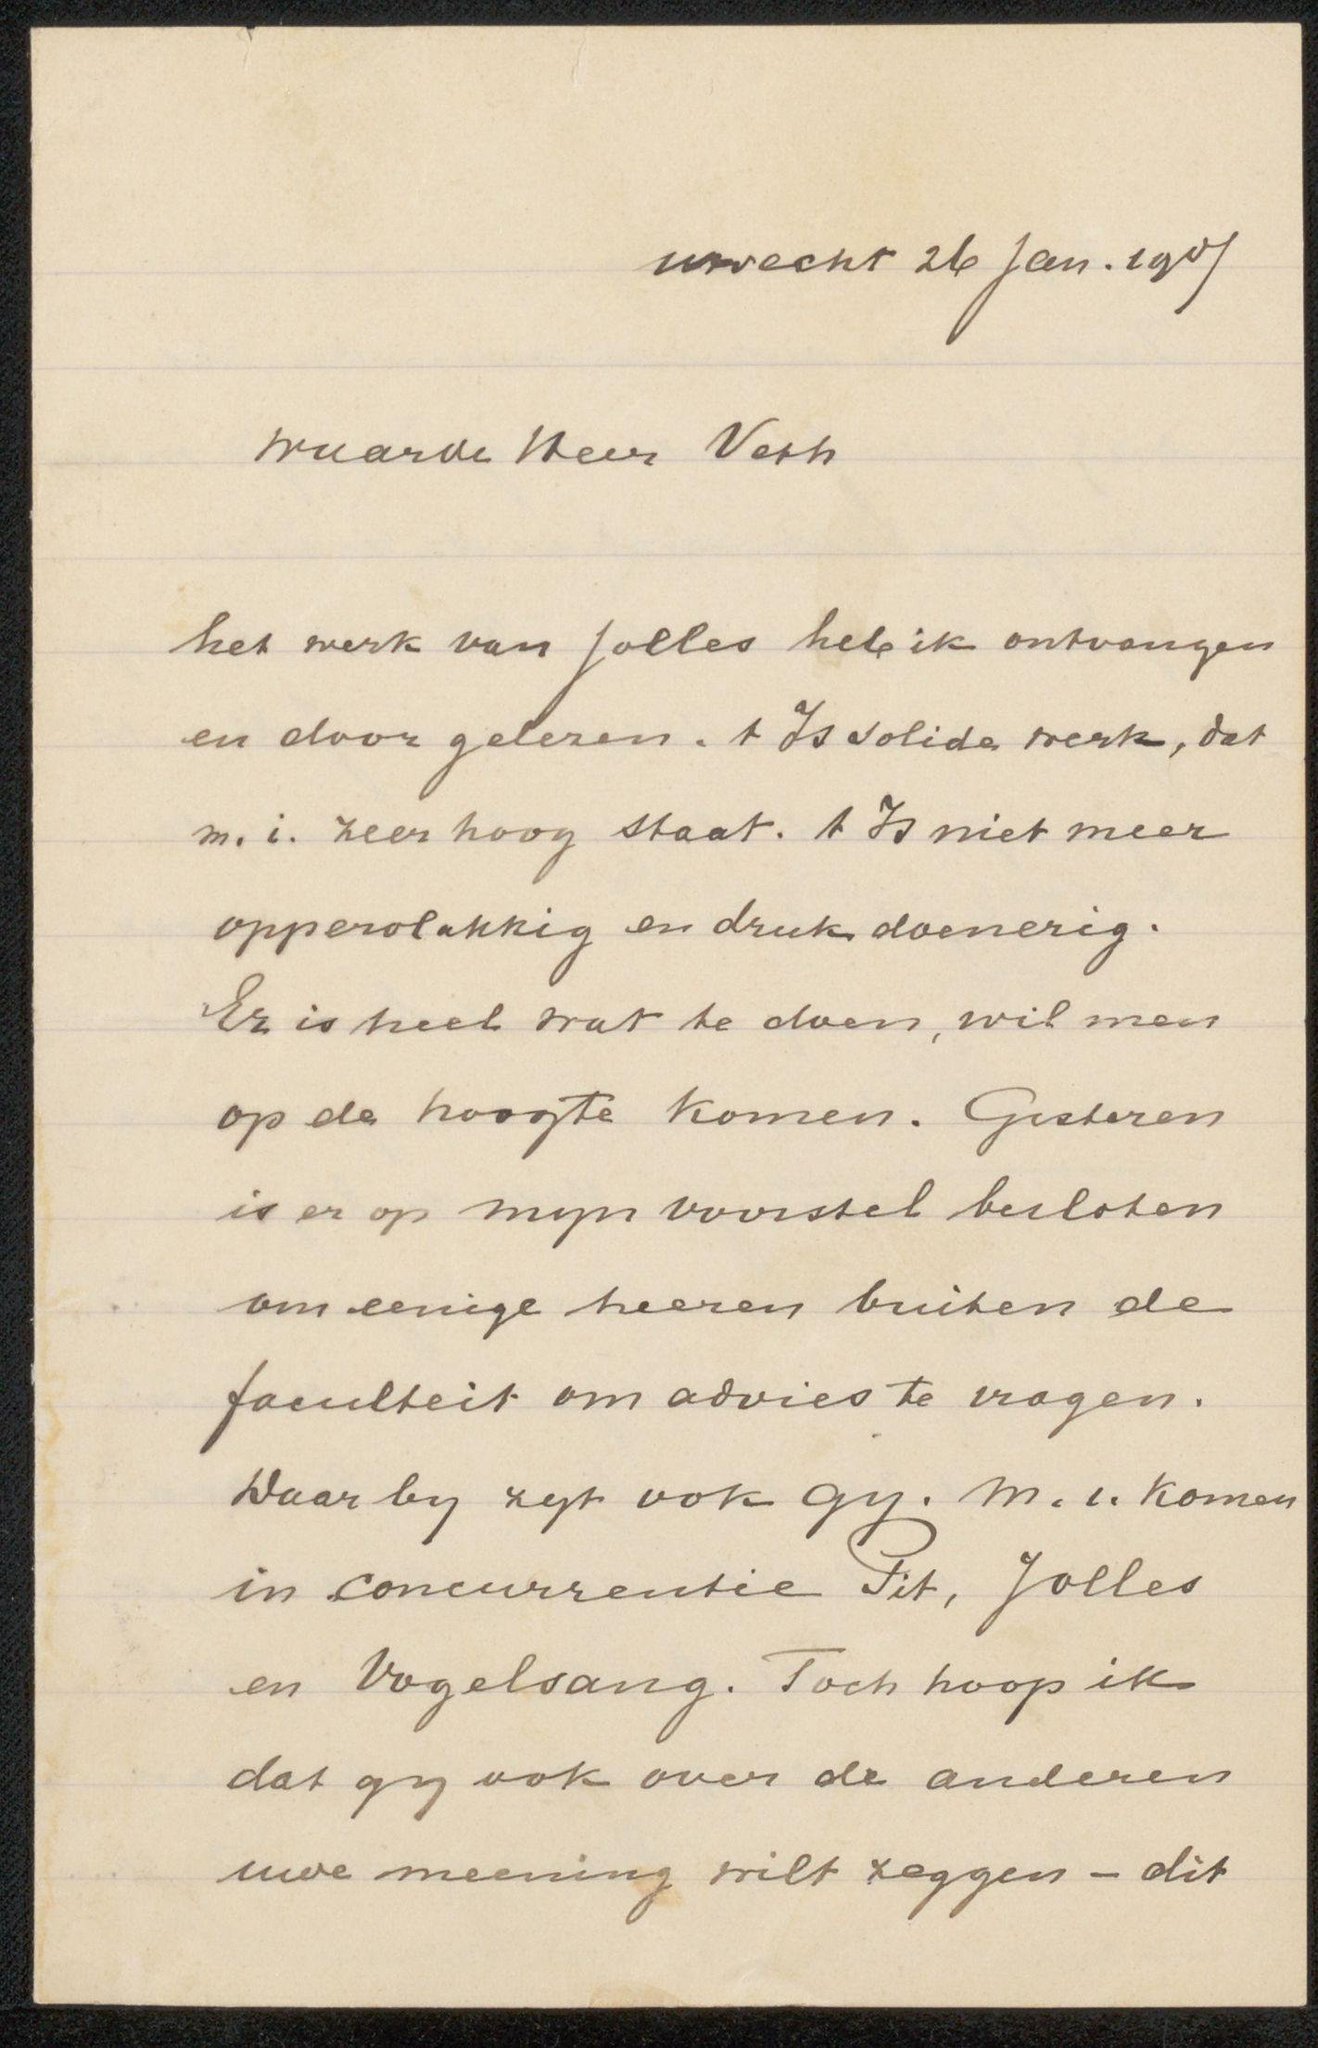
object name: letter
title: Brief aan Jan Veth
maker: johan hendrik gallée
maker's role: hoogleraar, taalkundige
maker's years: 1847-1908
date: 1907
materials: ink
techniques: pen, writing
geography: utrecht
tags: dordrecht, amsterdam, painter, draughtsman, designer, jan veth, the hague, nijmegen, adriaan pit, leiden, willem vogelsang, andré jolles, anonymous historical person portrayed, painting (including book-illumination, miniature-painting)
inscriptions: collector's mark: ‘RPK’